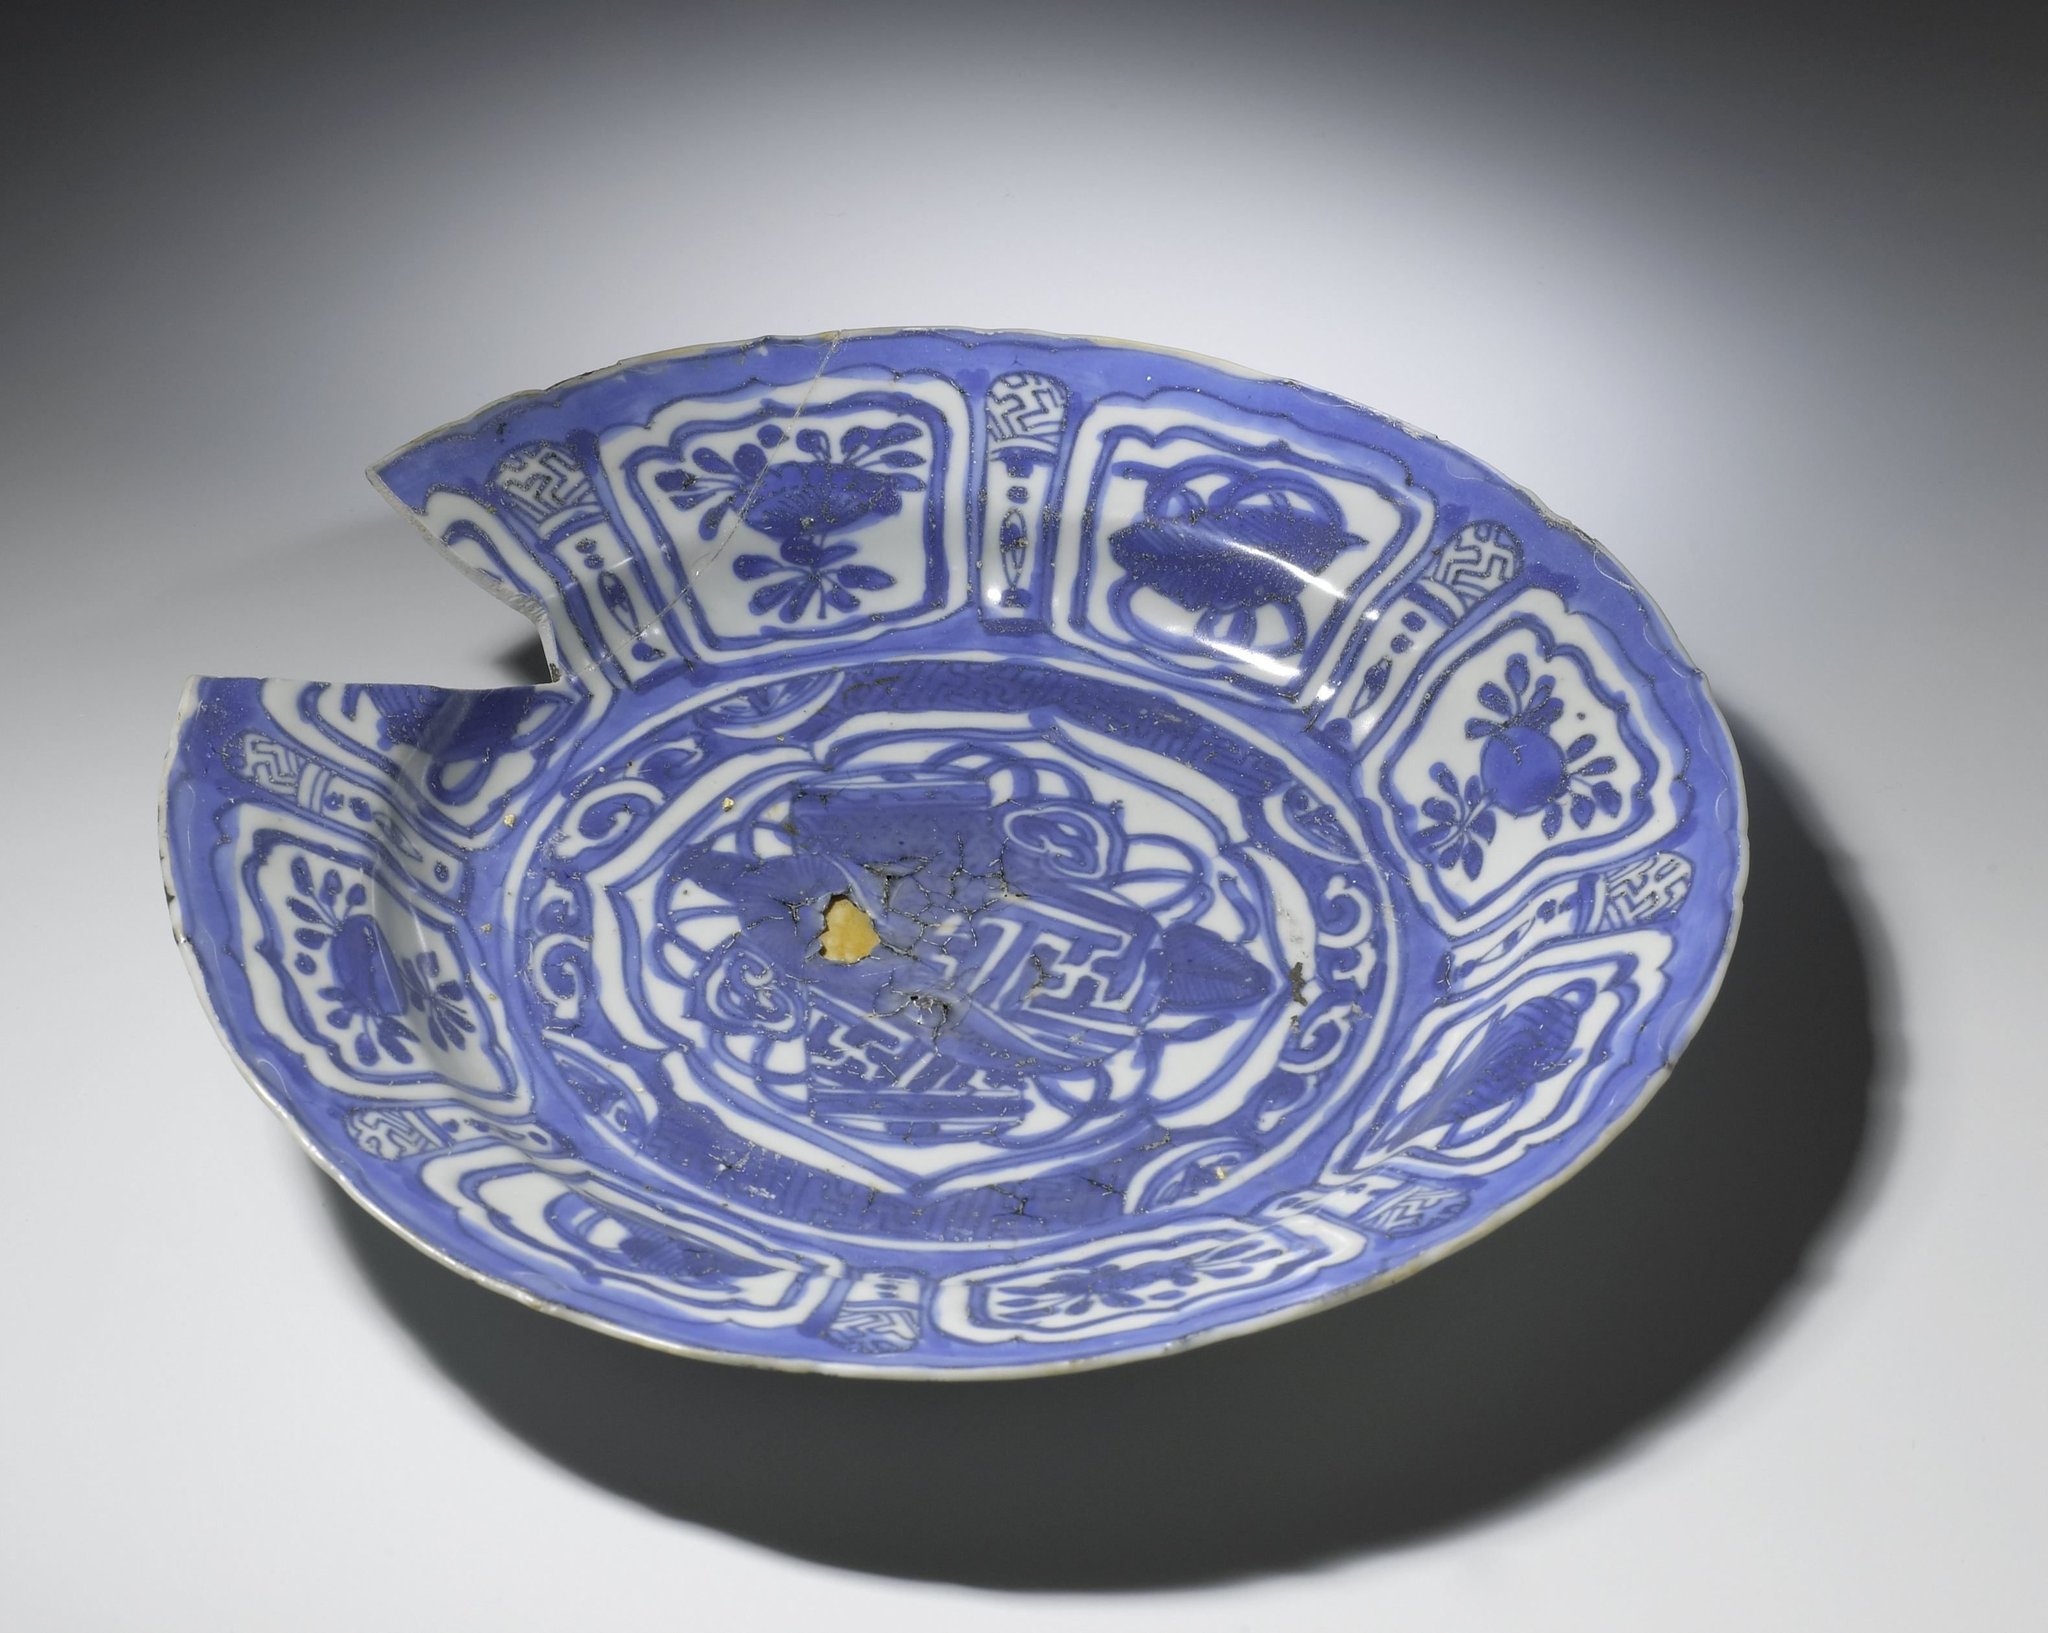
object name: plate dish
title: Bord uit V.O.C.-schip de 'Witte Leeuw'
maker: Anonymous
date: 1613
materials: bone china, porcelain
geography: jingdezhen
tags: verenigde oostindische compagnie, sint-helena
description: Bord uit V.O.C.-schip de 'Witte Leeuw' met een platte rand en een geschulpte lip, gedecoreerd in onderglazuur blauw, 98% aanwezig. In het plat geluksymbolen omgeven door een accoladevorige band met gestileerde ranken en geomterische motieven. Op de wand en rand brede en smalle velde gevuld met geluksymbolen en bloemtakken. Het kobalt en glazuur in het plat zijn gedeeltelijk verbrand in de oven en onder in vloed van het zoute water afgesprongen.